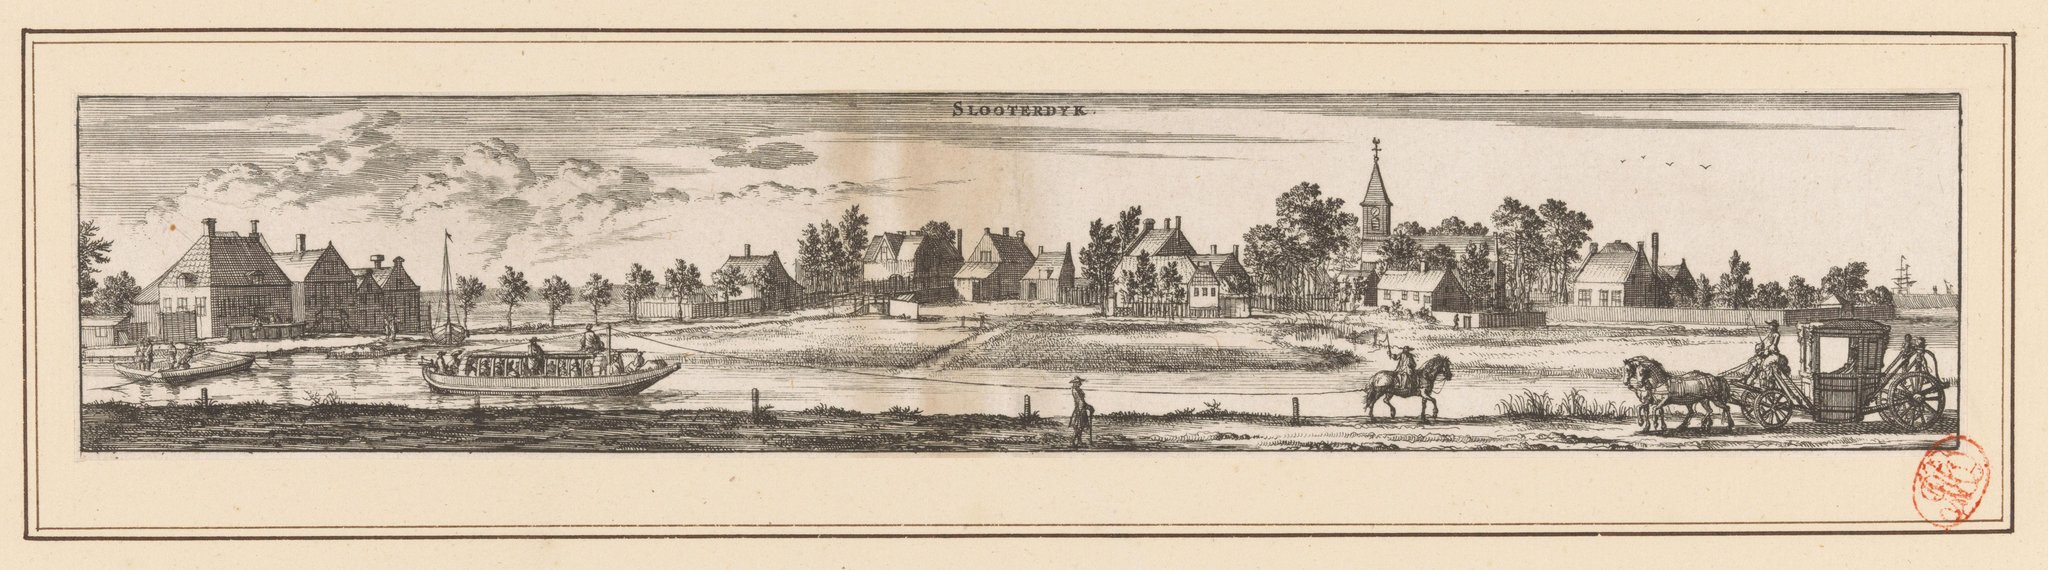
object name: book illustration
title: Slooterdyk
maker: jan luyken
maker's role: draughtsman, print maker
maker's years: 1649-1712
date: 1693-1726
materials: paper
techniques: etching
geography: amsterdam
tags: prospect of village, silhouette of village, sailing-ship, sailing-boat, church (exterior), four-wheeled vehicle drawn by two animals, boat propelled by man or animal, sloterdijk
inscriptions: collector's mark: Lugt 195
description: Deze afbeelding is afgesneden van een prent met vier voorstellingen (zie RP-P-1896-A-19368-940). Zie ook RP-P-AO-8-19 en RP-P-AO-9-52. De hele prent is ook gebruikt in: Commelin, Caspar. Beschryvinge van Amsterdam, desselfs eerste oorspronk uyt den Huyse (…). 2 delen. Amsterdam: Abraham Wolfgang, Gillis Janssonius van Waesberge, Johannes Janssonius van Waesberge II, weduwe Dirk Boom I, Hendrick Boom en Rembertus Goethals, 1693, dl. 2, p. 872. En in: Commelin, Caspar. Beschryvinge van Amsterdam, zynde een naukeurige verhandelinge van desselfs eerste oorspronk uyt (…). 2 delen. Amsterdam: weduwe Aart Dircksz Oossaan, 1694, dl. 2. En in: Commelin, Caspar. Beschryvinge van Amsterdam, zynde een naukeurige verhandelinge van desselfs eerste oorspronk uyt (…). 2 delen. 2e druk. Amsterdam: Andries van Damme, Johannes Ratelband, weduwe A. van Aaltwyk en Hermanus Uytwerf, 1726, dl. 2.